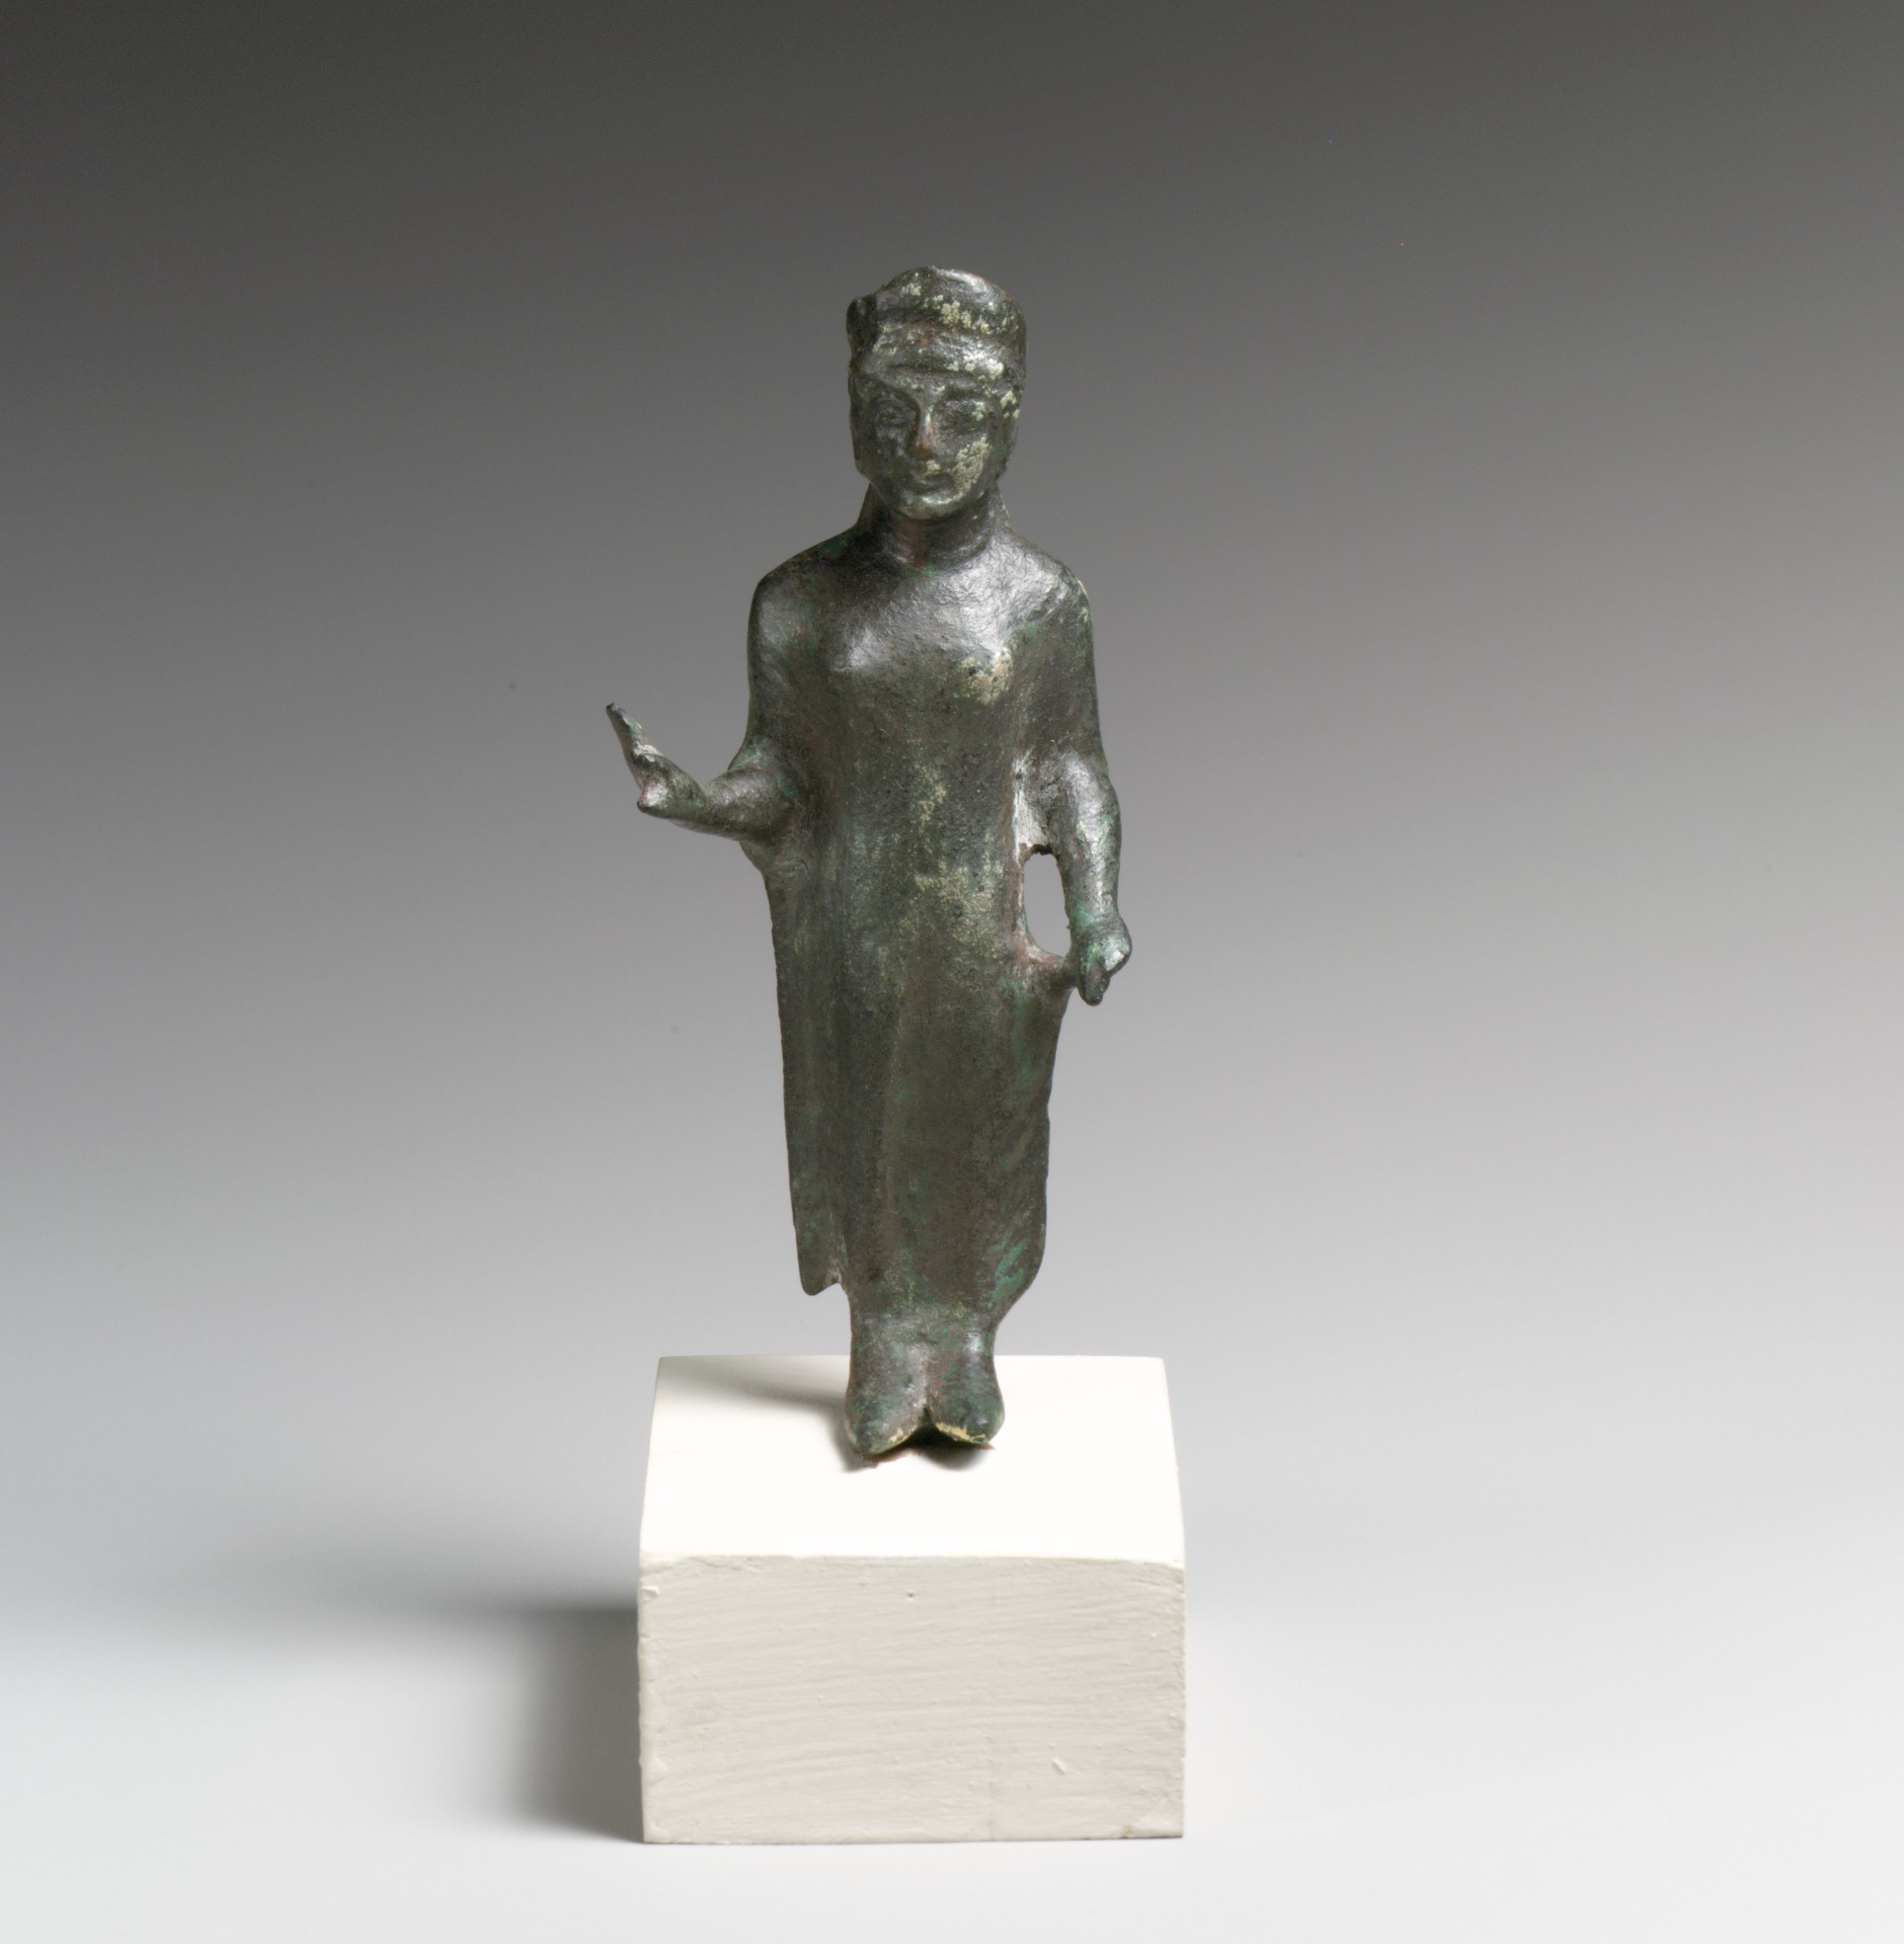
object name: statuette of a woman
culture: etruscan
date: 400-301 BCE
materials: bronze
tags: women